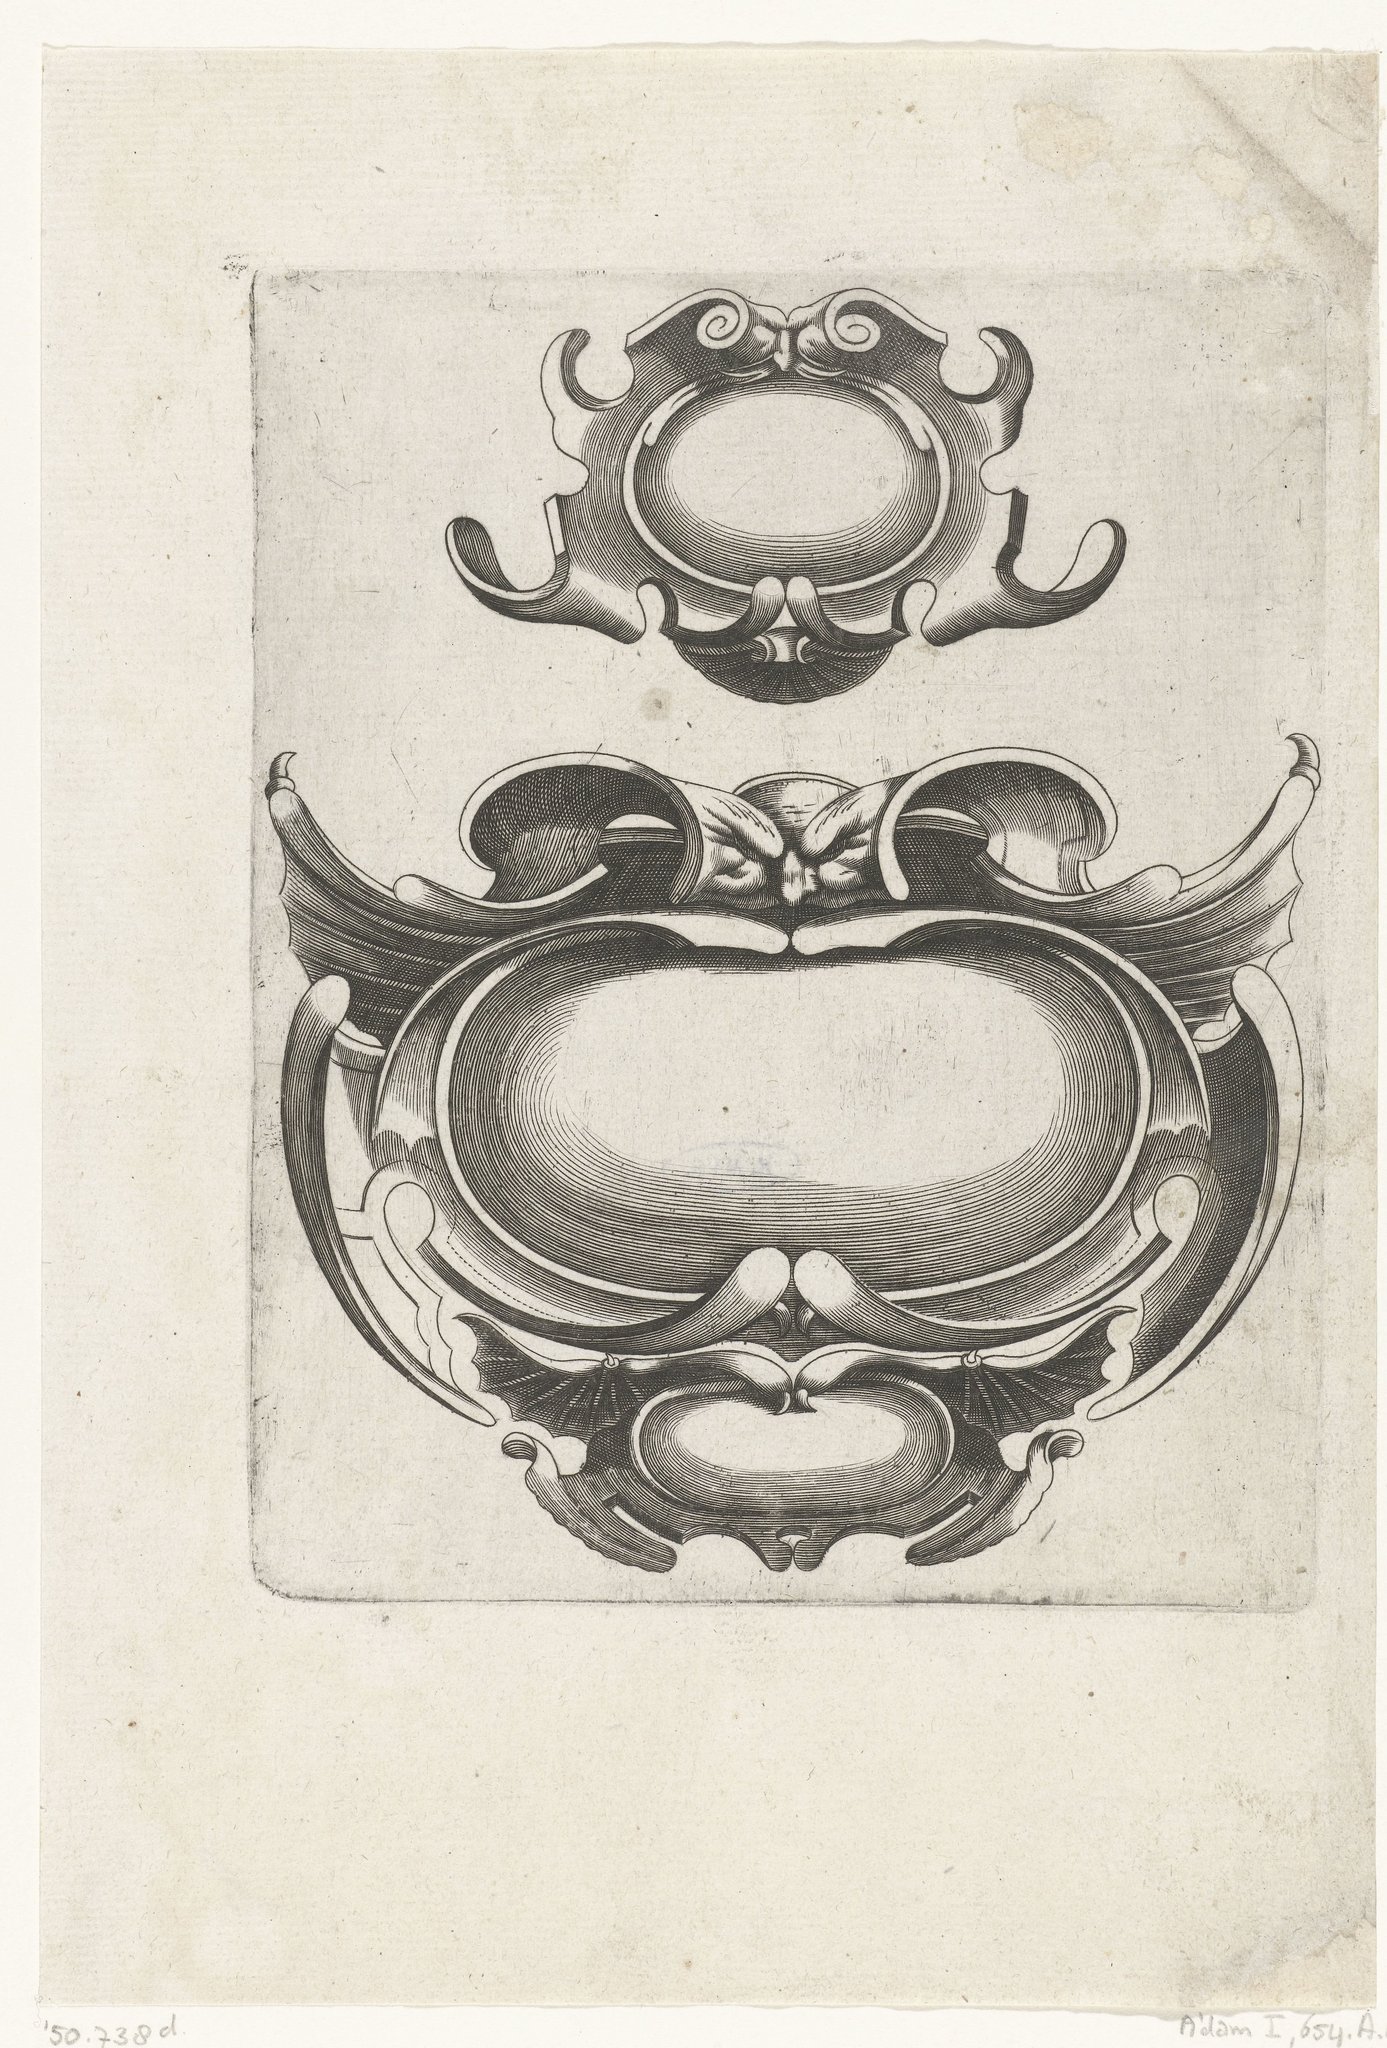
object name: ornament print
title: Cartouches in omlijstingen van rolwerk met grotesken, guirlandes en mascarons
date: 1628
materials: paper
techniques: engraving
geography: france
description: De onderste cartouche is groter dan de bovenste, in de omlijsting van rolwerk is midden boven een mascaron verwerkt. Tegenzijdige kopie naar blad 4 uit serie met cartouches in omlijstingen van rolwerk met grotesken, guirlandes en mascarons uitgegeven door Pierre Mariette.